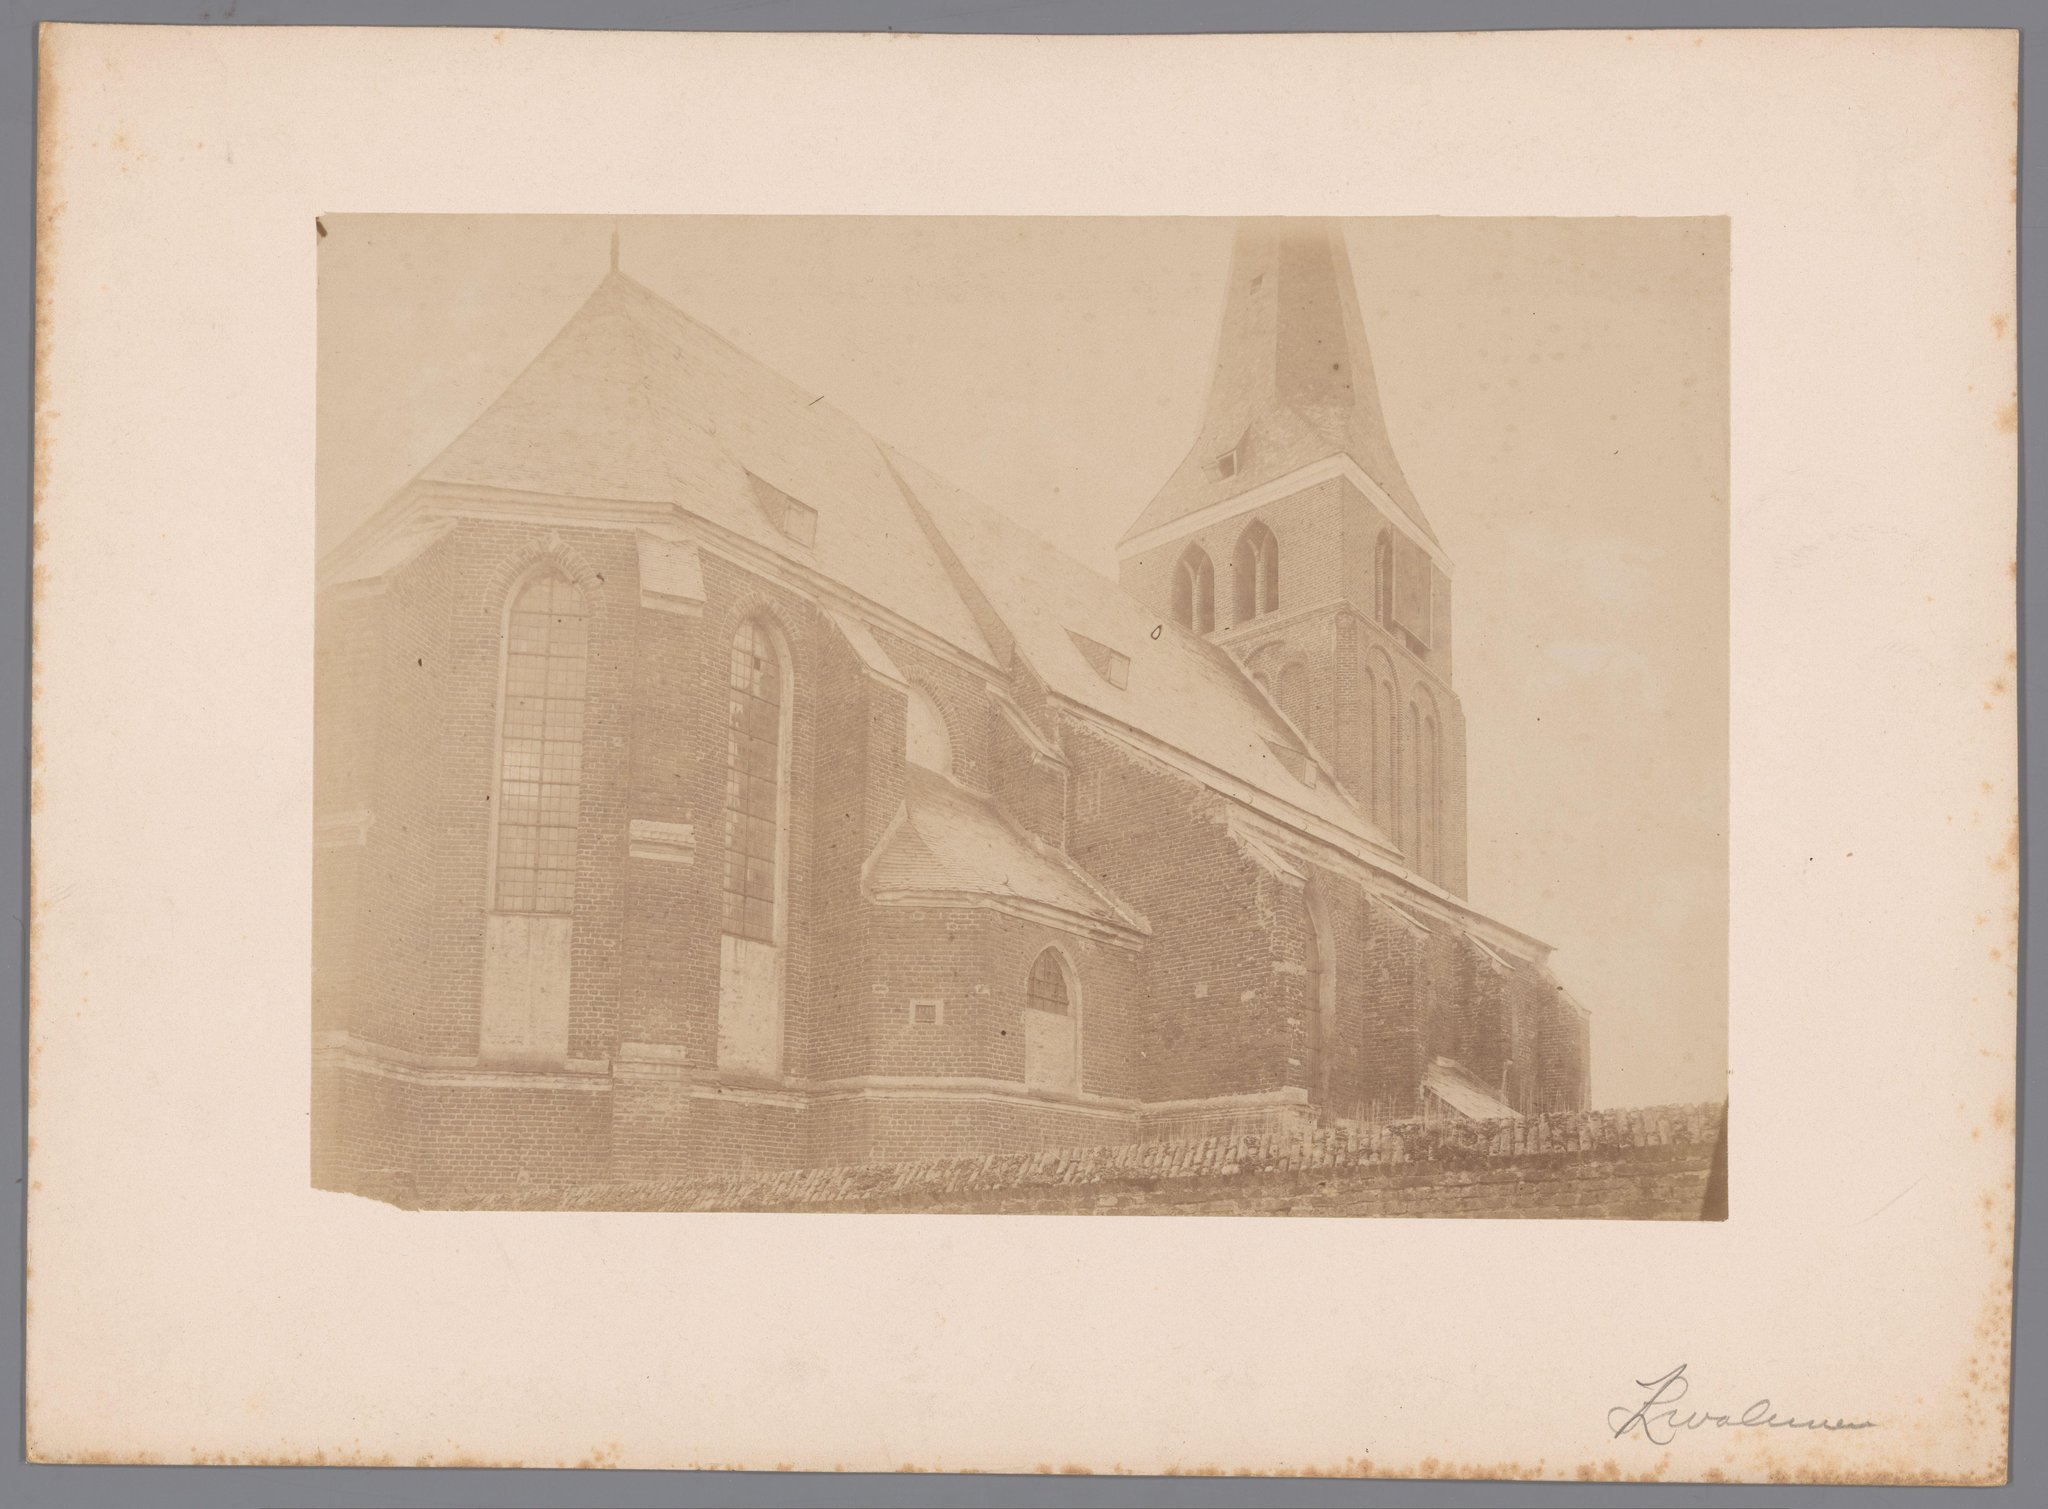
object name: photograph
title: Gezicht op de Sint-Lambertuskerk te Swalmen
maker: anoniem (monumentenzorg)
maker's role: fotograaf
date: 1895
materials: cardboard, photographic support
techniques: albumen print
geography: swalmen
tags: church (exterior)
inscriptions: annotation: ‘R.K. kerk te Swalmen (L.)/ Nov 1895’, annotation: ‘Swalmen’